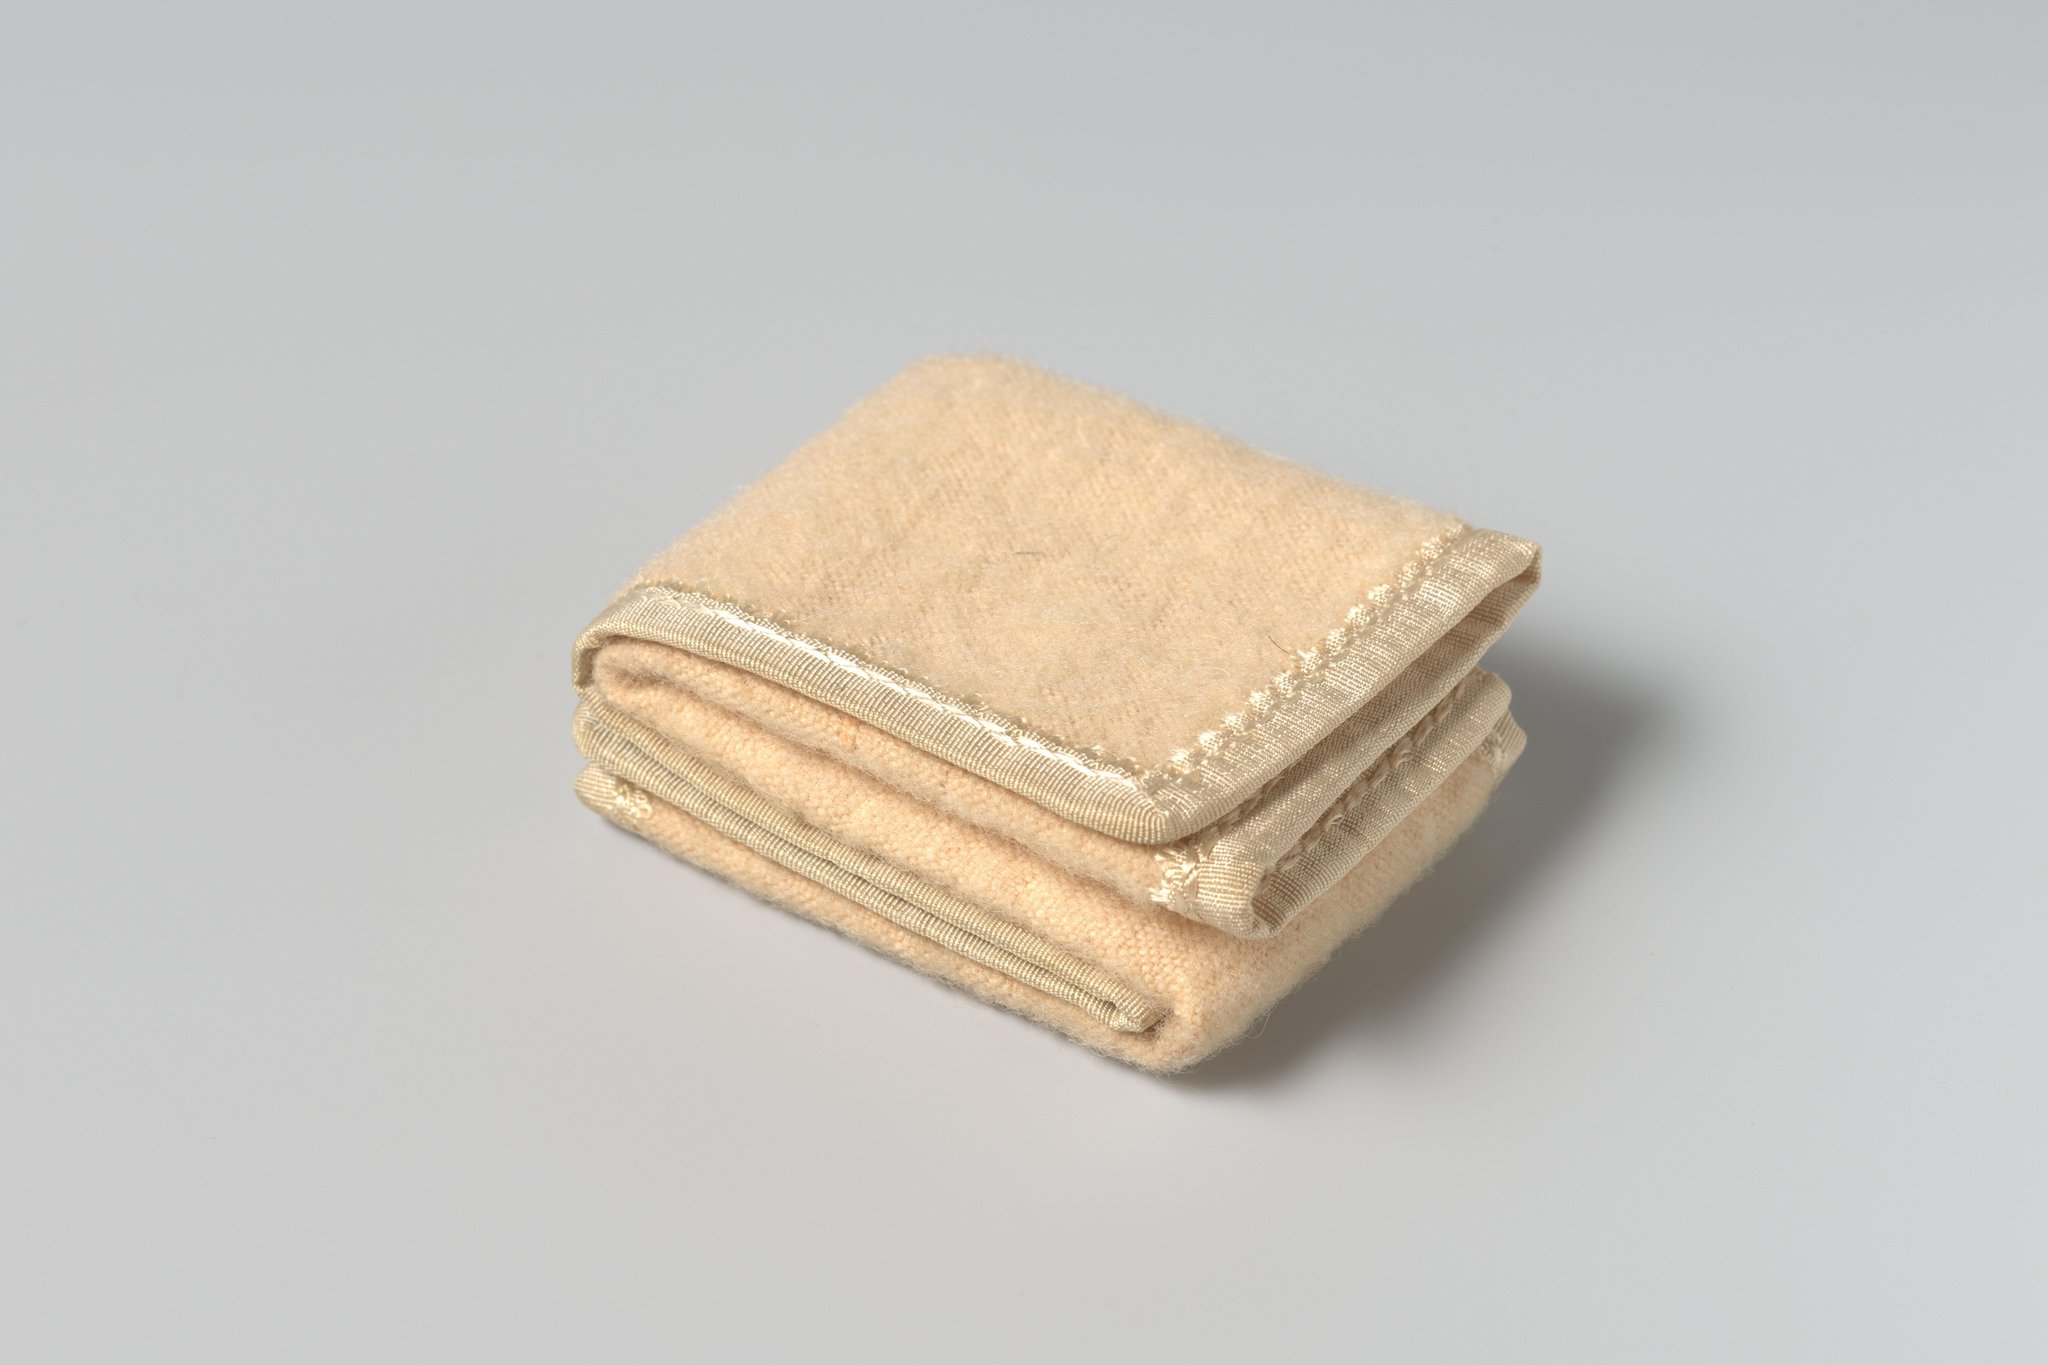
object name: miniature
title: Deken van witte wol, afgezet met blauwe zijden band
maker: Anonymous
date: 1676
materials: silk, wool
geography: amsterdam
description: Deken van witte geruwde wol, afgezet met blauwe zijden band met zigzag-patroon en lussen.